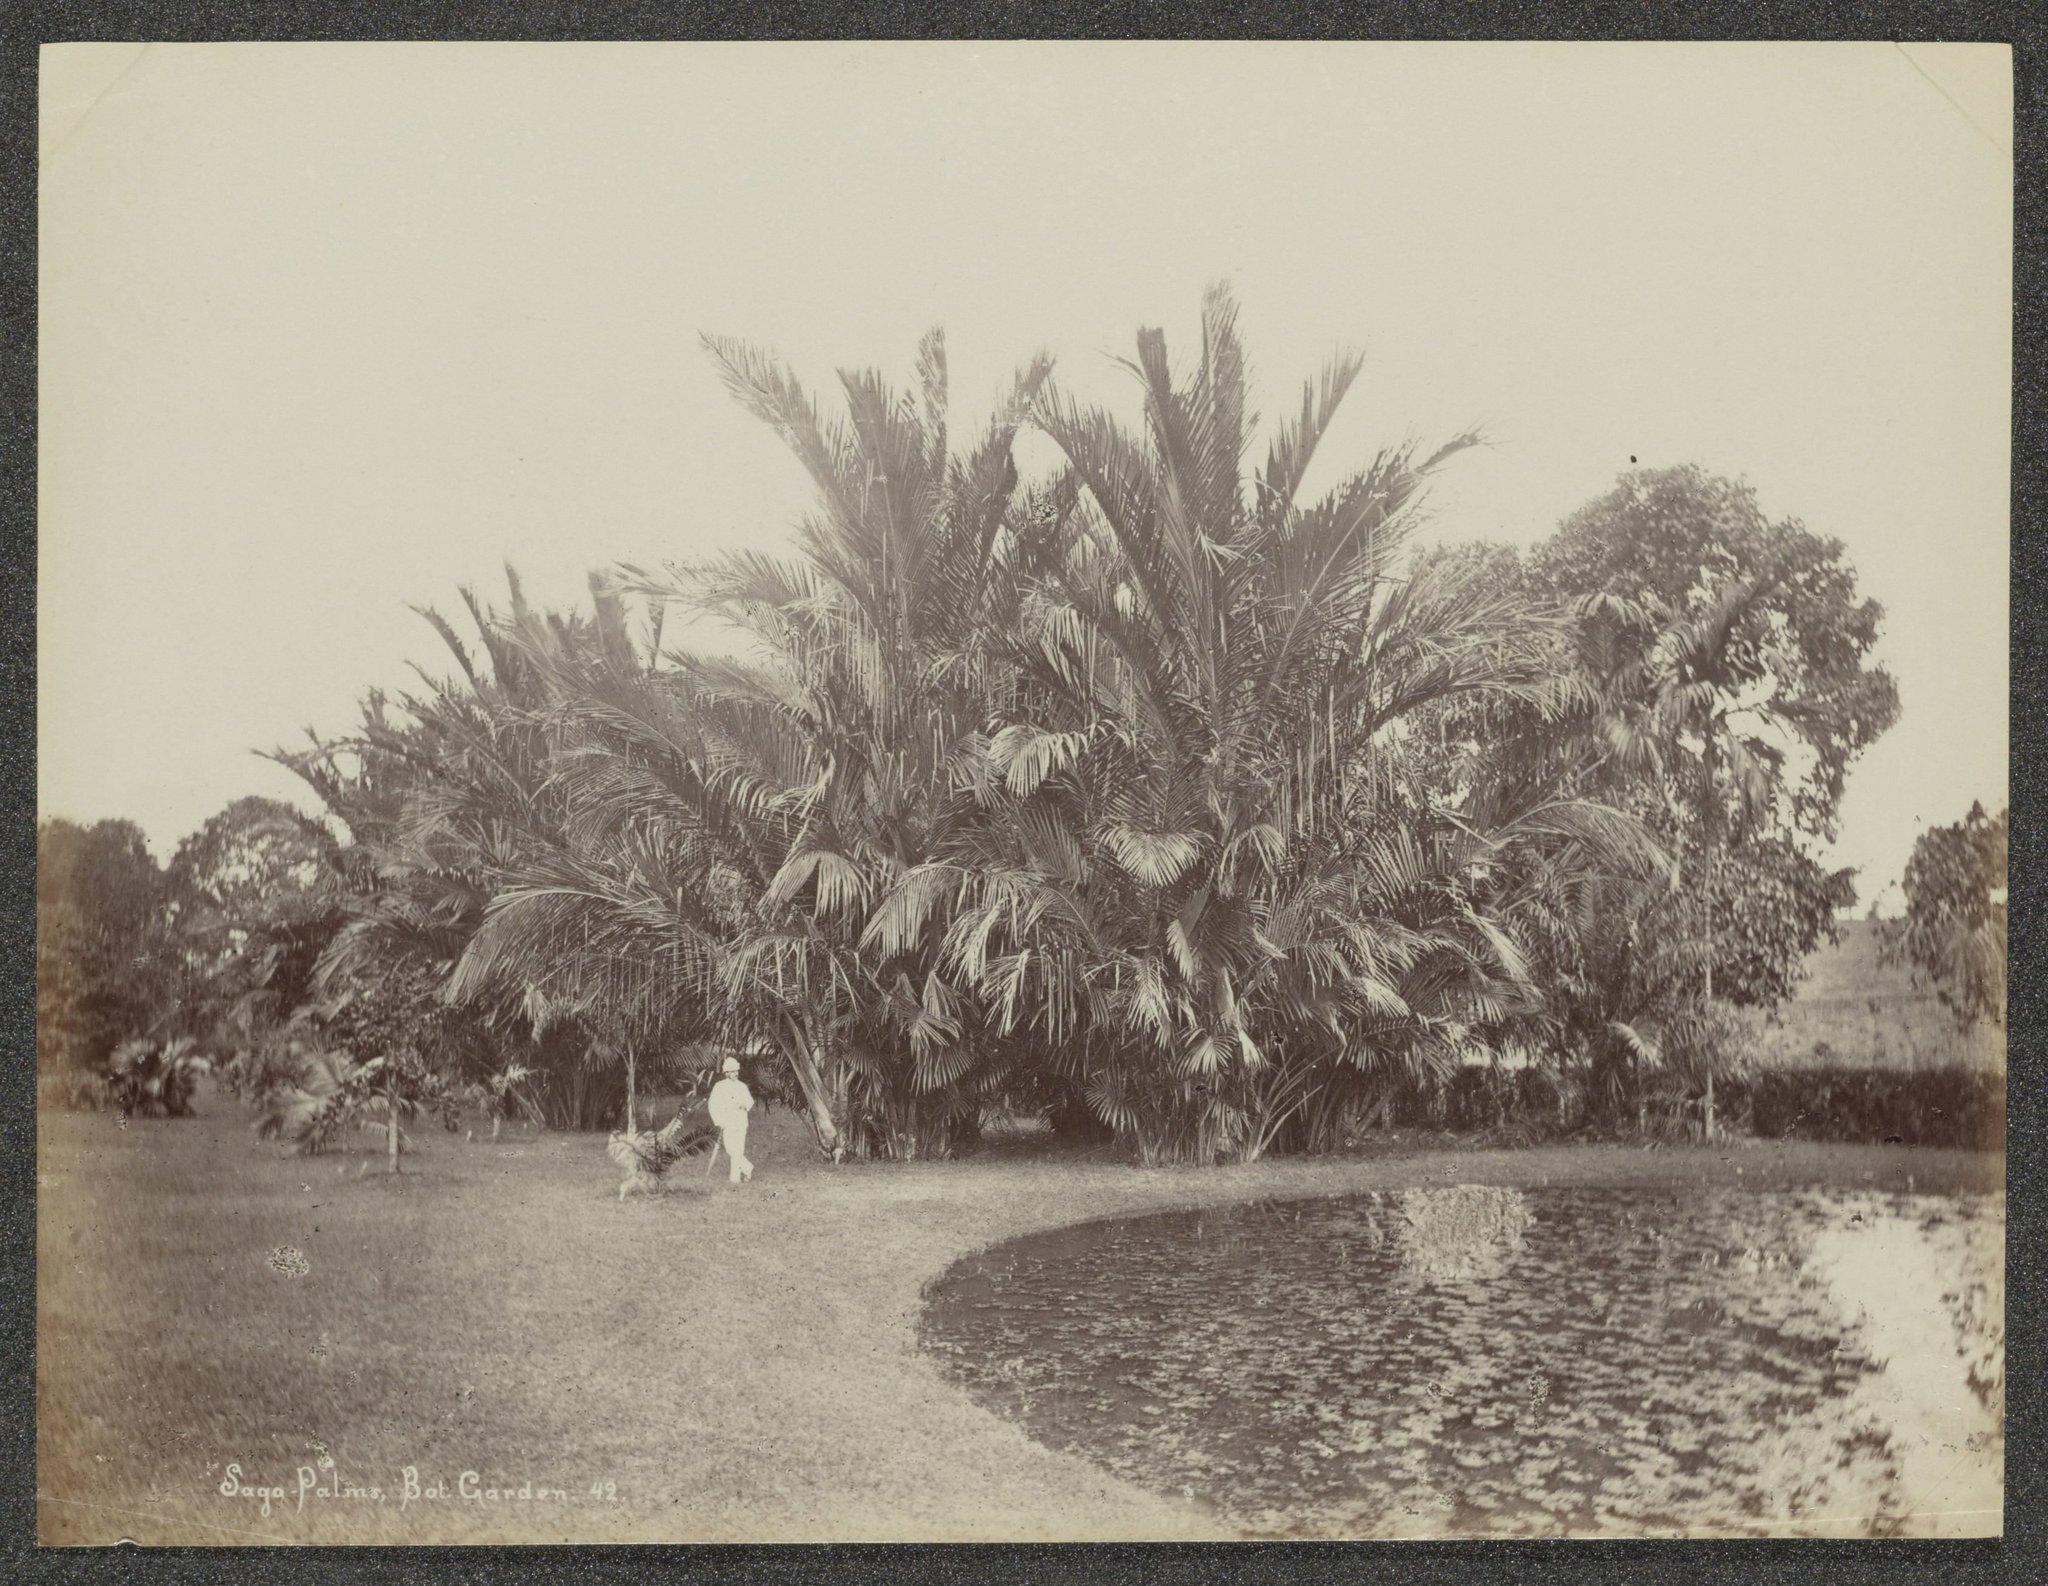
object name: album leaf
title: Saga Palms, Bot. Garden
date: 1870-1900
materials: paper, photographic support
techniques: albumen print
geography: singapore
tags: botanic garden, 'hortus botanicus', singapore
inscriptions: check stamp: ‘G.R. Lambert Singapore’, negative number: ‘42’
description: Onderdeel van Album met 50 foto's van een reis door Zuidoost-Azië.